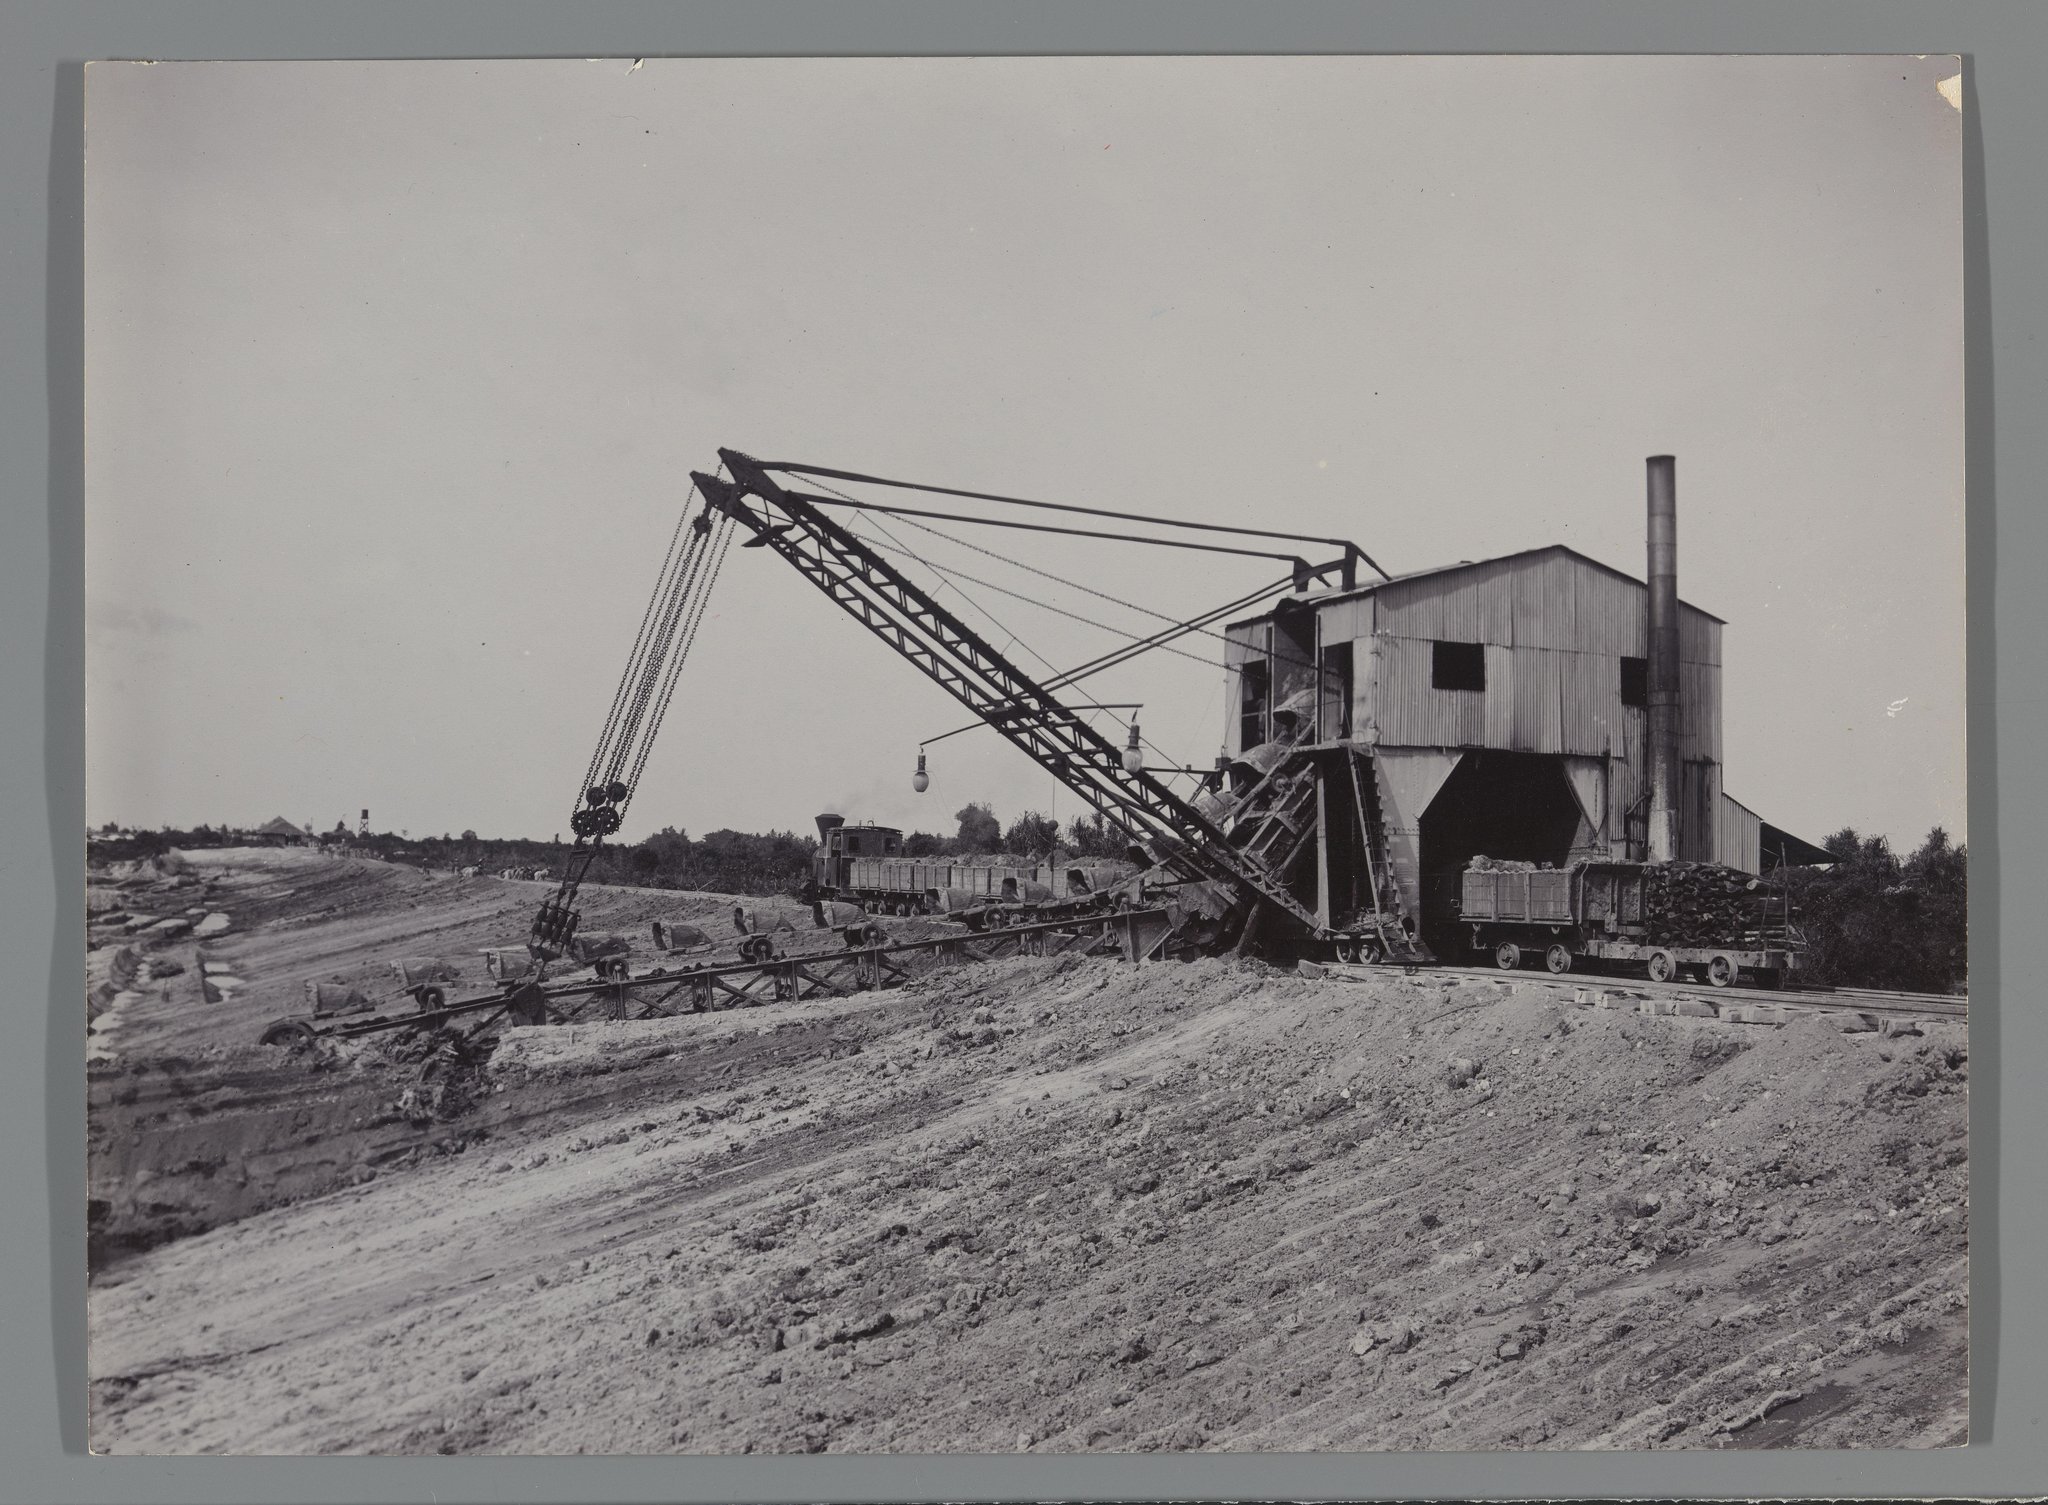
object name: photograph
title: Excavateur bedrijf in mijn 36 Soengeiliat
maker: Anonymous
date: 1914-1919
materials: photographic support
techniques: gelatin silver print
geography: bangka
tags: robert julius boers, opencast mine; strip mining, digging (industrial process)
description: Graafmachine in bedrijf bij een mijn te Soengeiliat. Onderdeel van een groep van losse foto's en tekeningen behorend bij het fotoalbum aangeboden aan Robert Julius Boers bij zijn vertrek naar Nederland in 1919 door het personeel van de Banka-tinwinning.